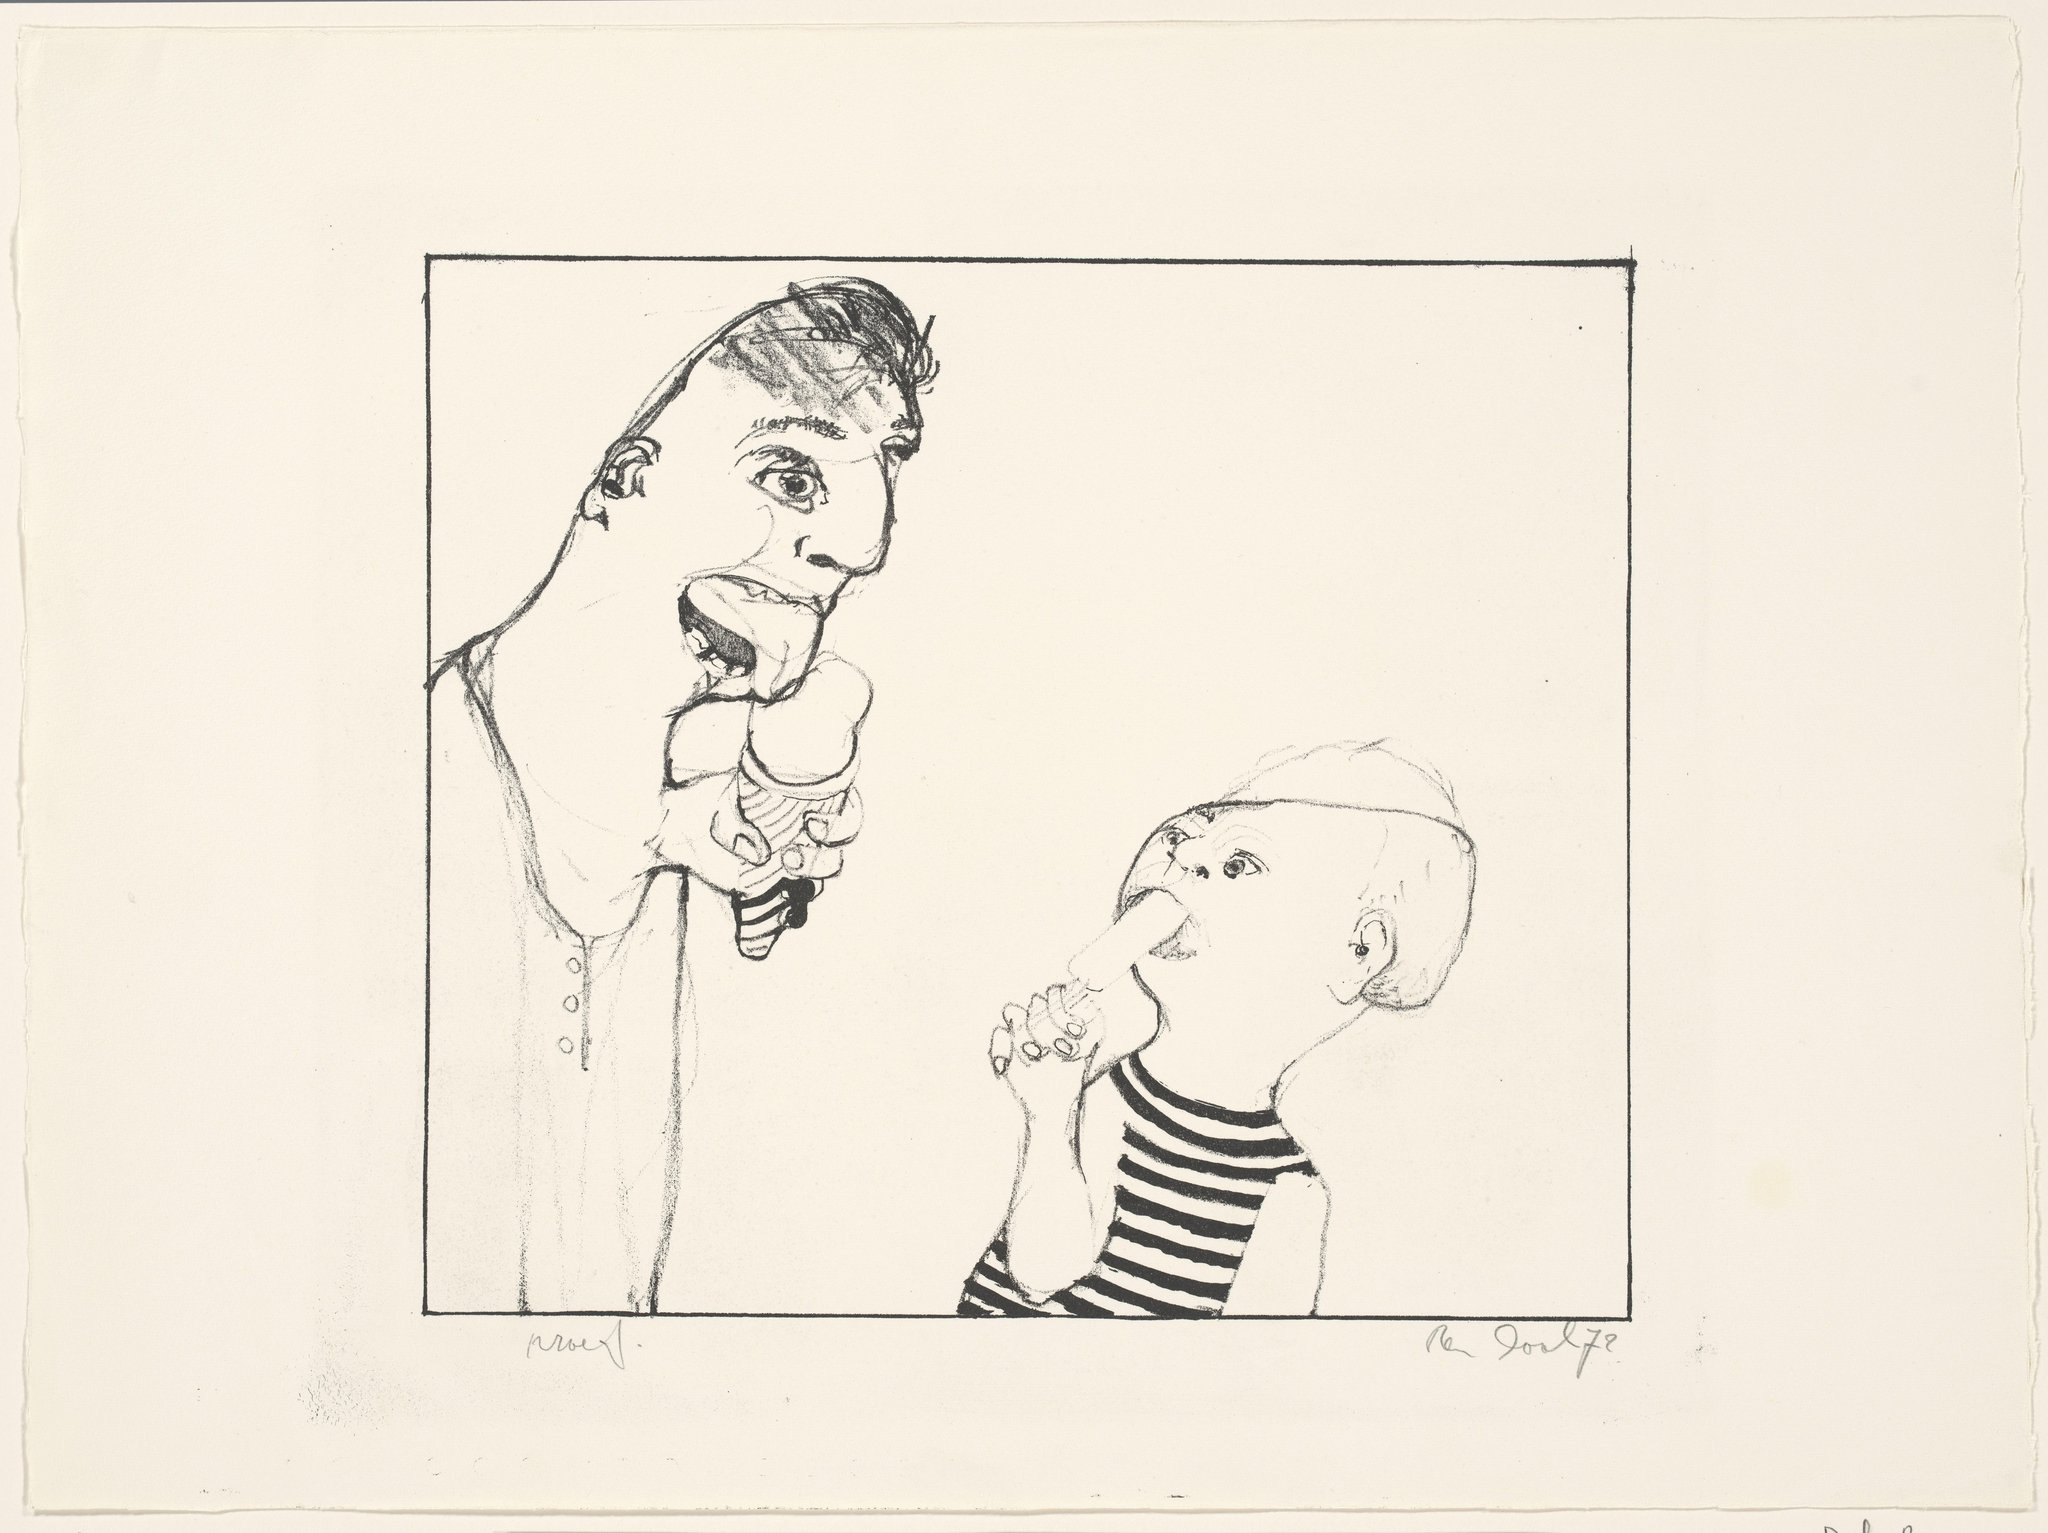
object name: print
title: IJs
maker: rein dool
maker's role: draughtsman, painter, print maker, sculptor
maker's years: 1933-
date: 1972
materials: paper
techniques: lithograph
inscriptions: signature and date